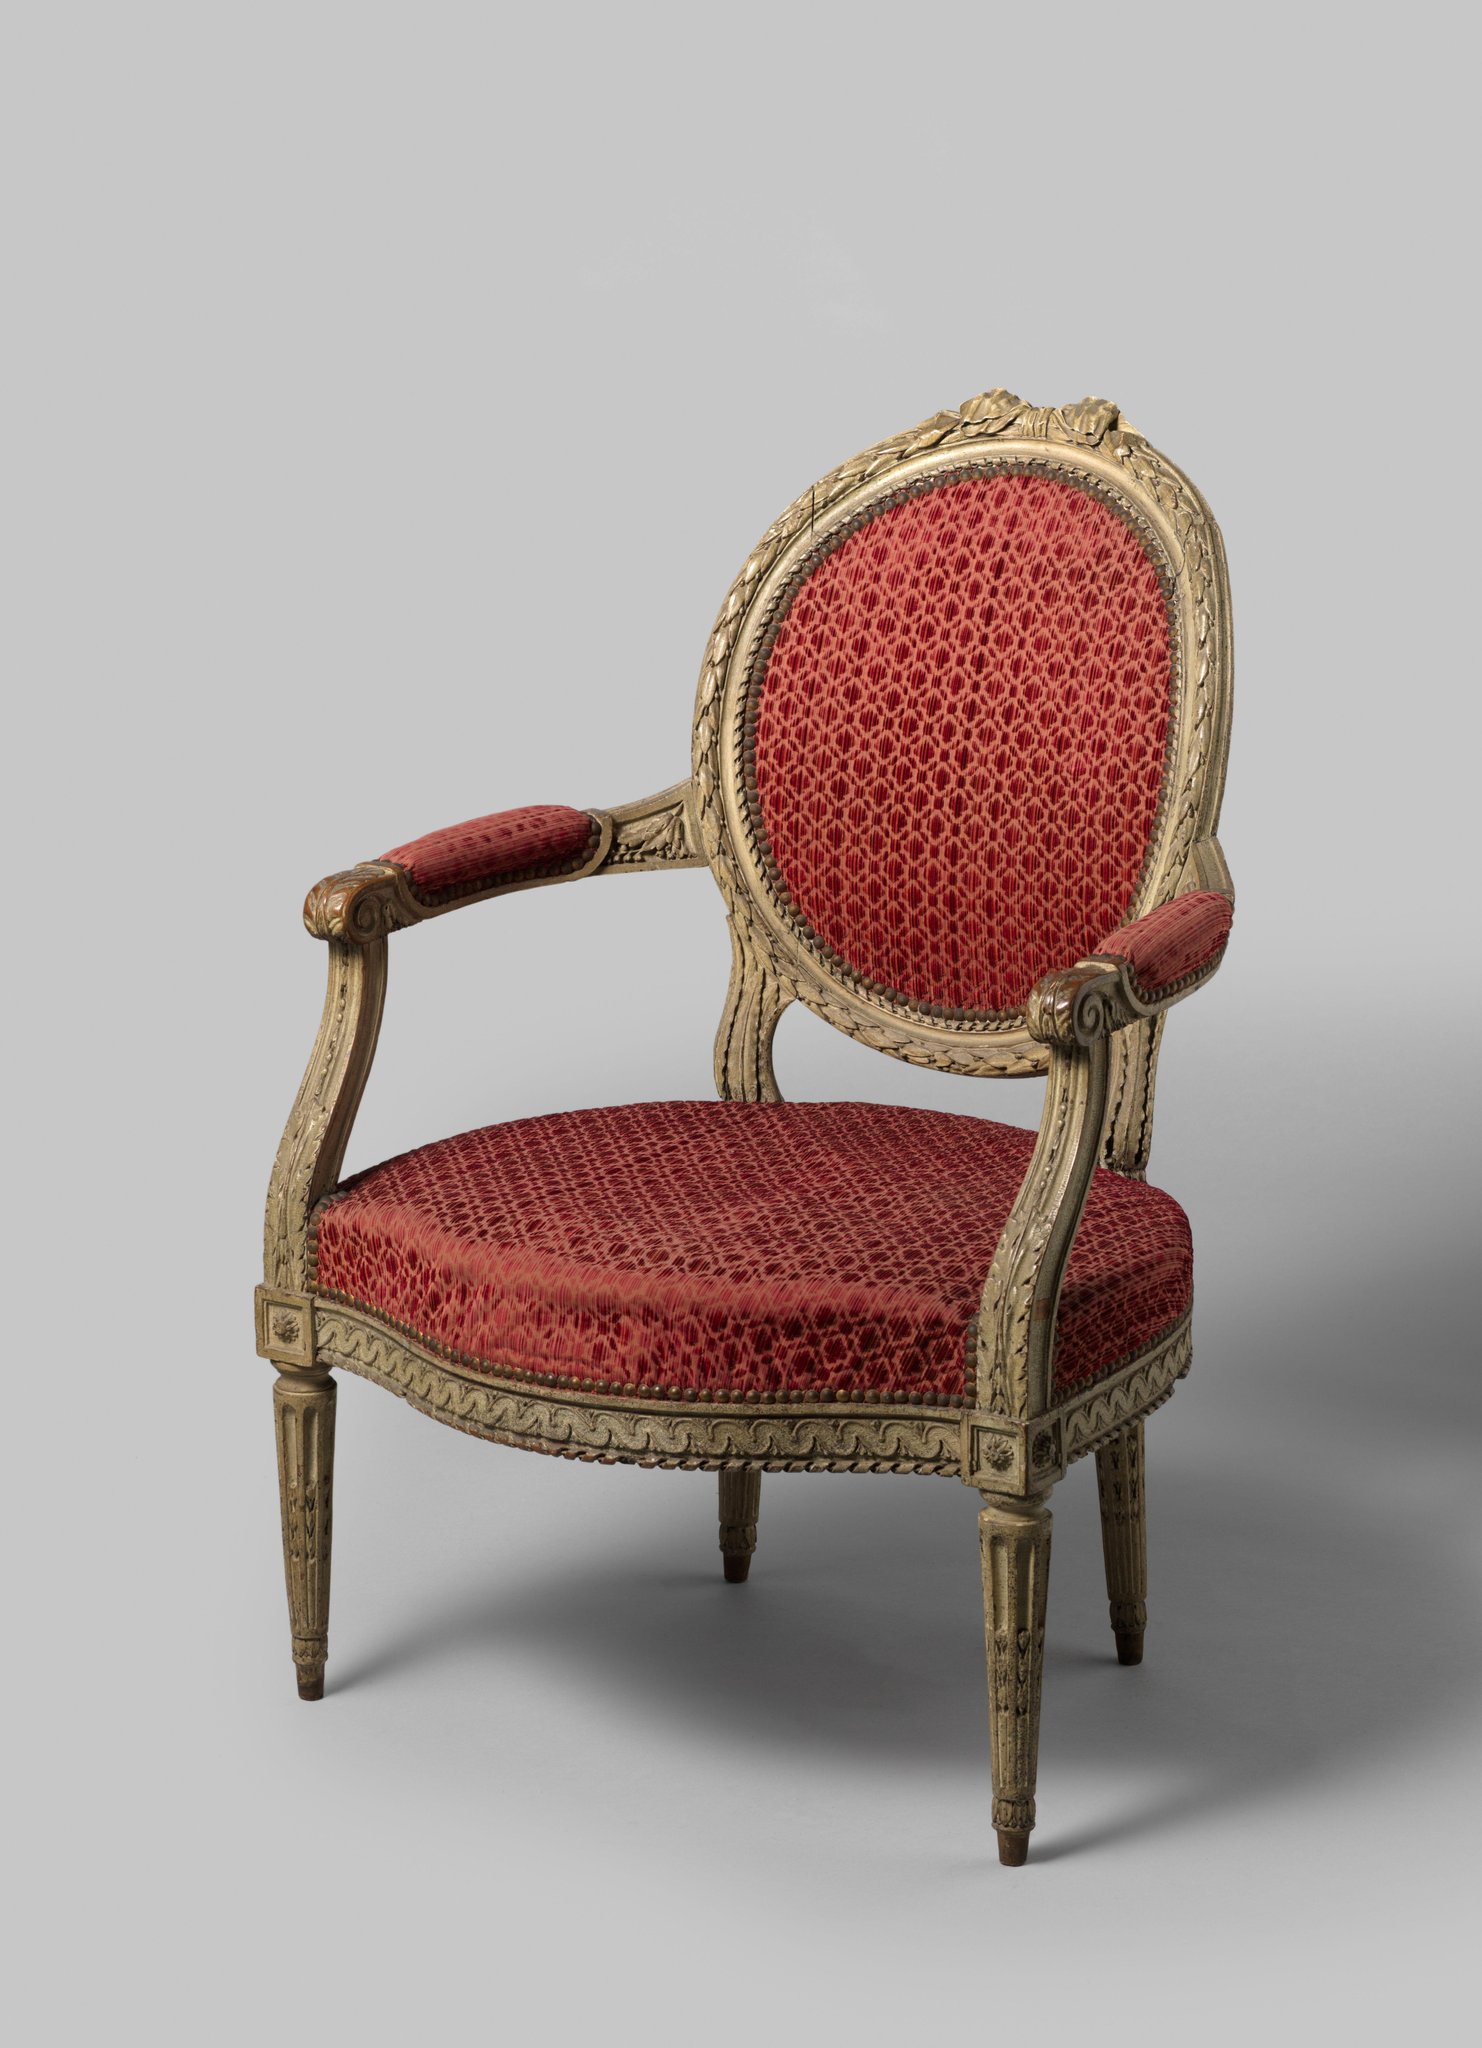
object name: armchair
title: Armstoel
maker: Anonymous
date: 1775-1800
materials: paint, textile, wood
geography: france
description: Armstoel, bekleed, van wit geschilderd notenhout, rustend op gecanneleerde conische poten. Het ronde zitraam is van voren geschulpt. De zitregels vertonen een gestoken geslingerde band boven een om een staaf gewonden lint. De C-vormige armleggers eindigen in een voluut met acanthusblad en hebben aan de binnenzijde een bloemkelk; de stutten zijn versierd met een kelksnoer tussen profielen en onderaan een acanthusblad. Het ovale rugraam, op buitenwaarts gebogen stutten, is omringd met lauwerkrans met strik.